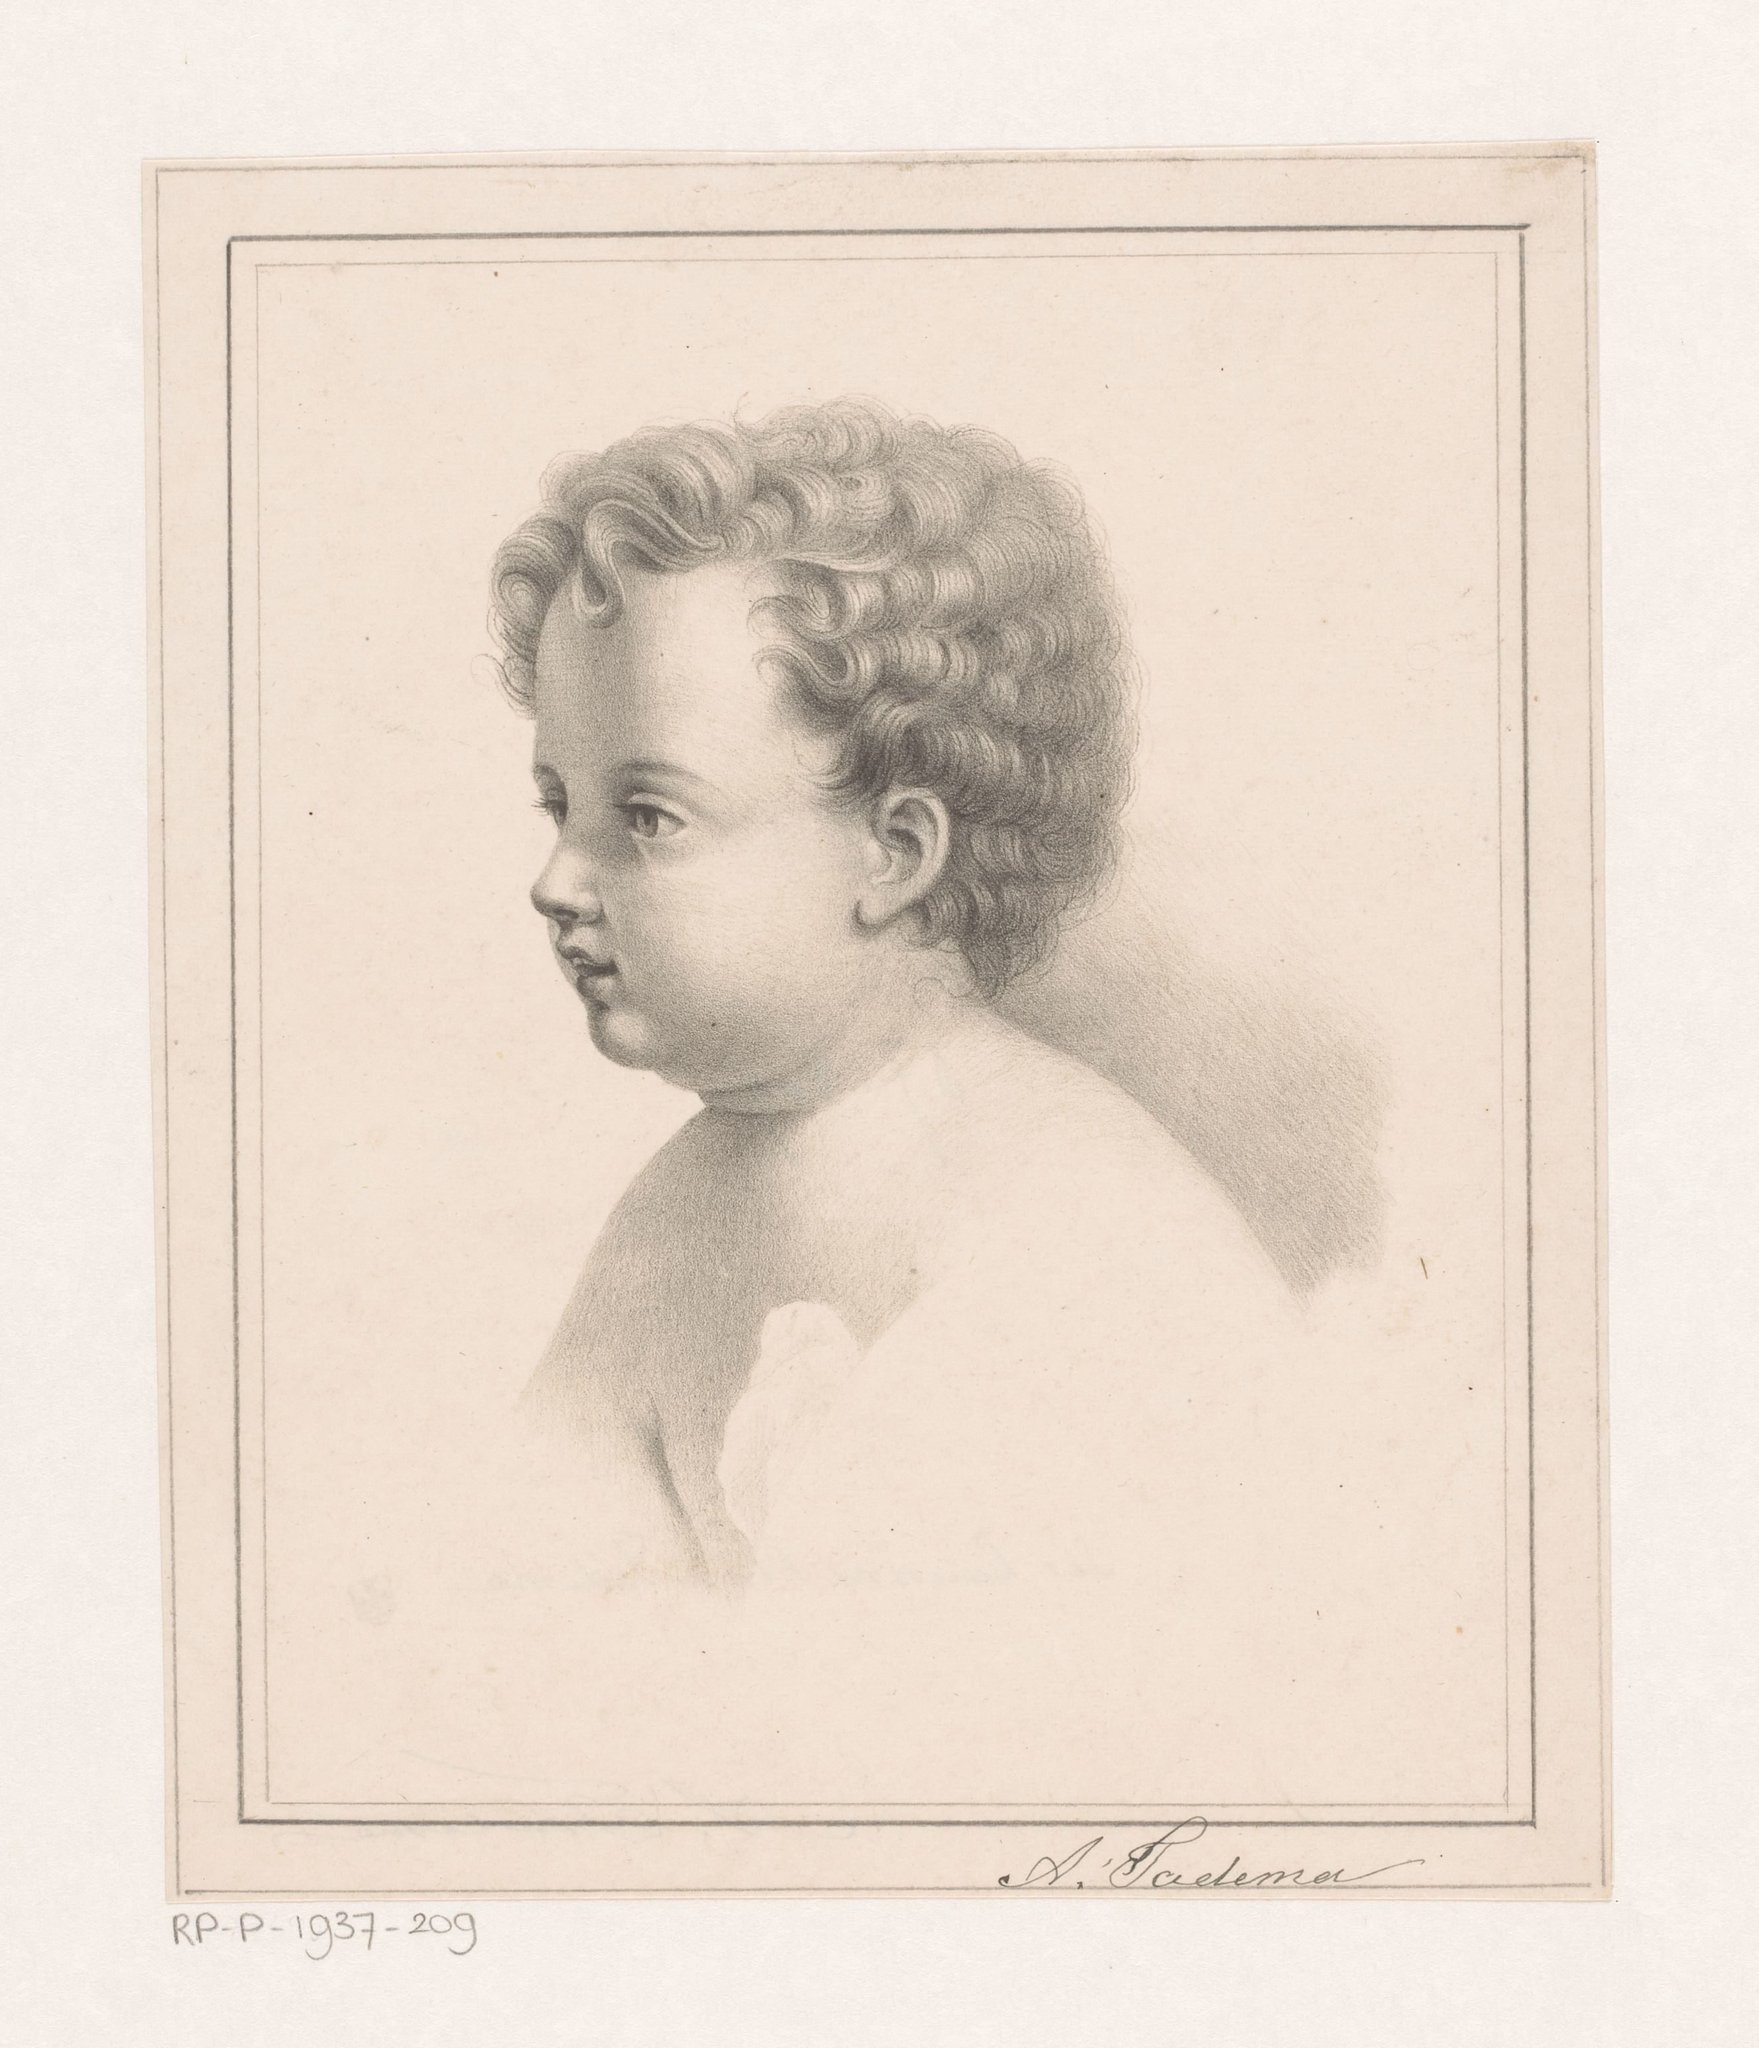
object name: print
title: Hoofd van een kind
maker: lourens alma tadema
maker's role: draughtsman, print maker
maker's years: 1836-1912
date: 1846-1912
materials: paper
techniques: lithograph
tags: child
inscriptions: collector's mark: Lugt 2760, collector's mark: Lugt 2228